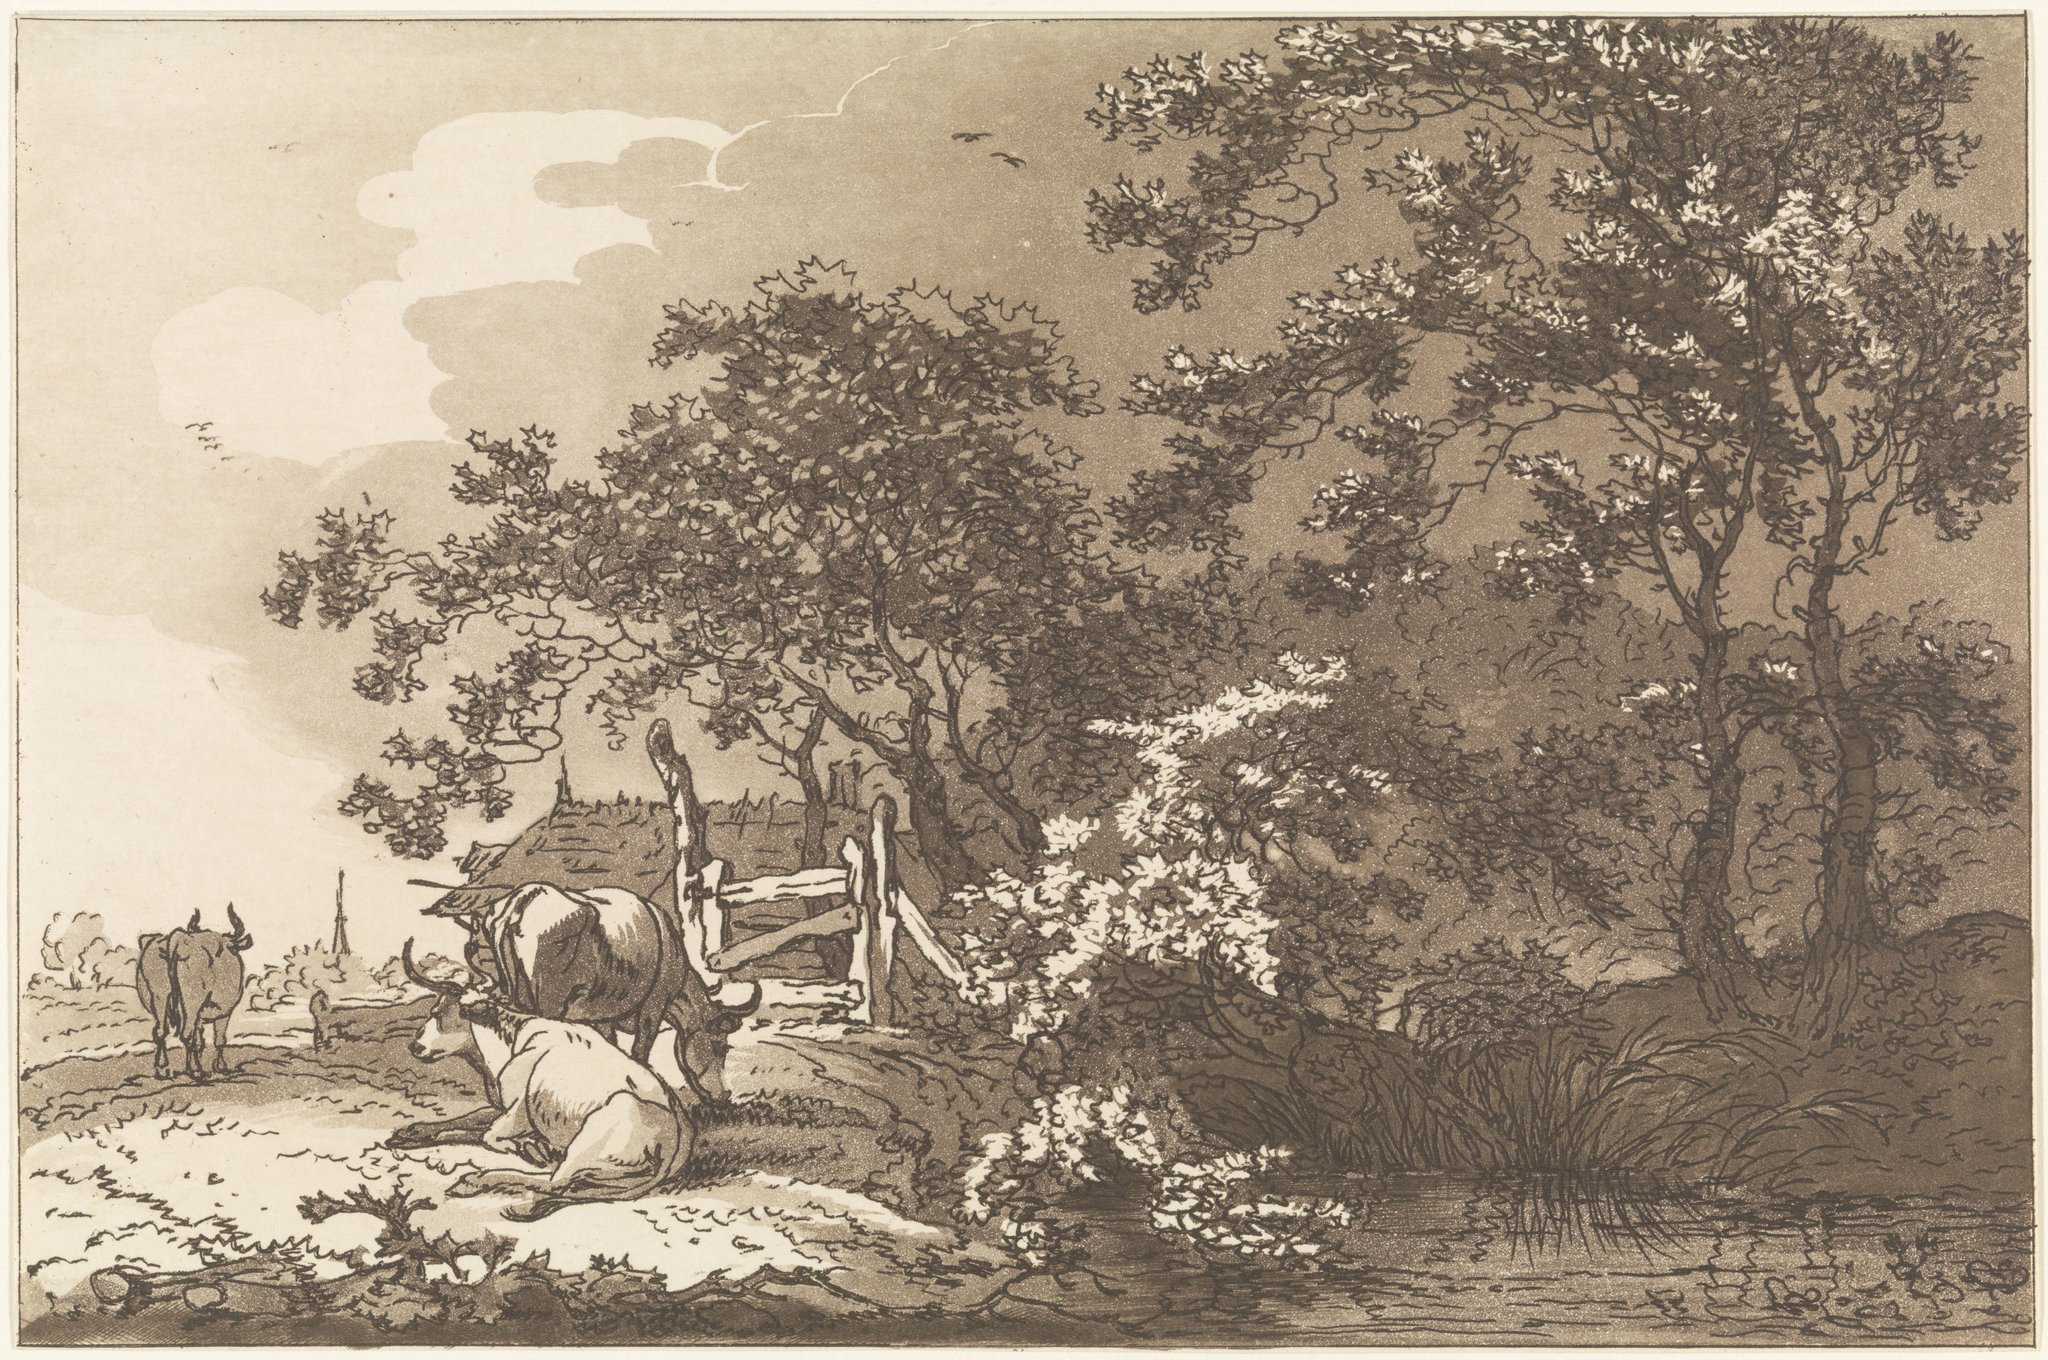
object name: print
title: Twelve designs Calculated for the Use of those who are Learning to Draw Landscape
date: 1789-1793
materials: paper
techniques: aquatint, etching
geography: london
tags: cow, meadow, pasture, pond, pool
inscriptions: collector's mark: Lugt 2228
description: Een landschap met drie koeien in een weiland bij een hek. Rechts een waterpoel.